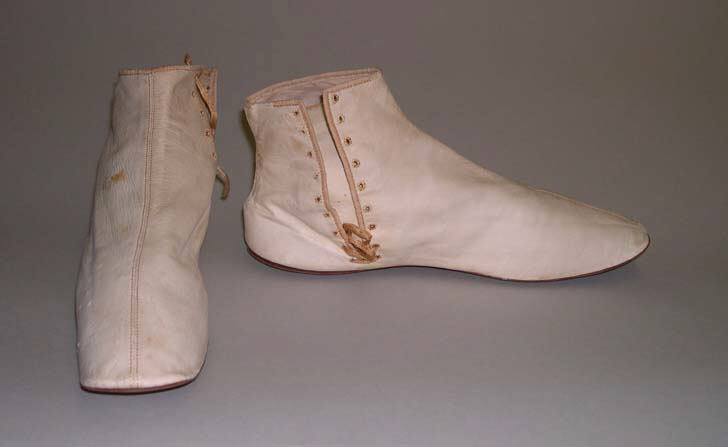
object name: shoe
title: Shoes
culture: american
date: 1830-1839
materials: leather